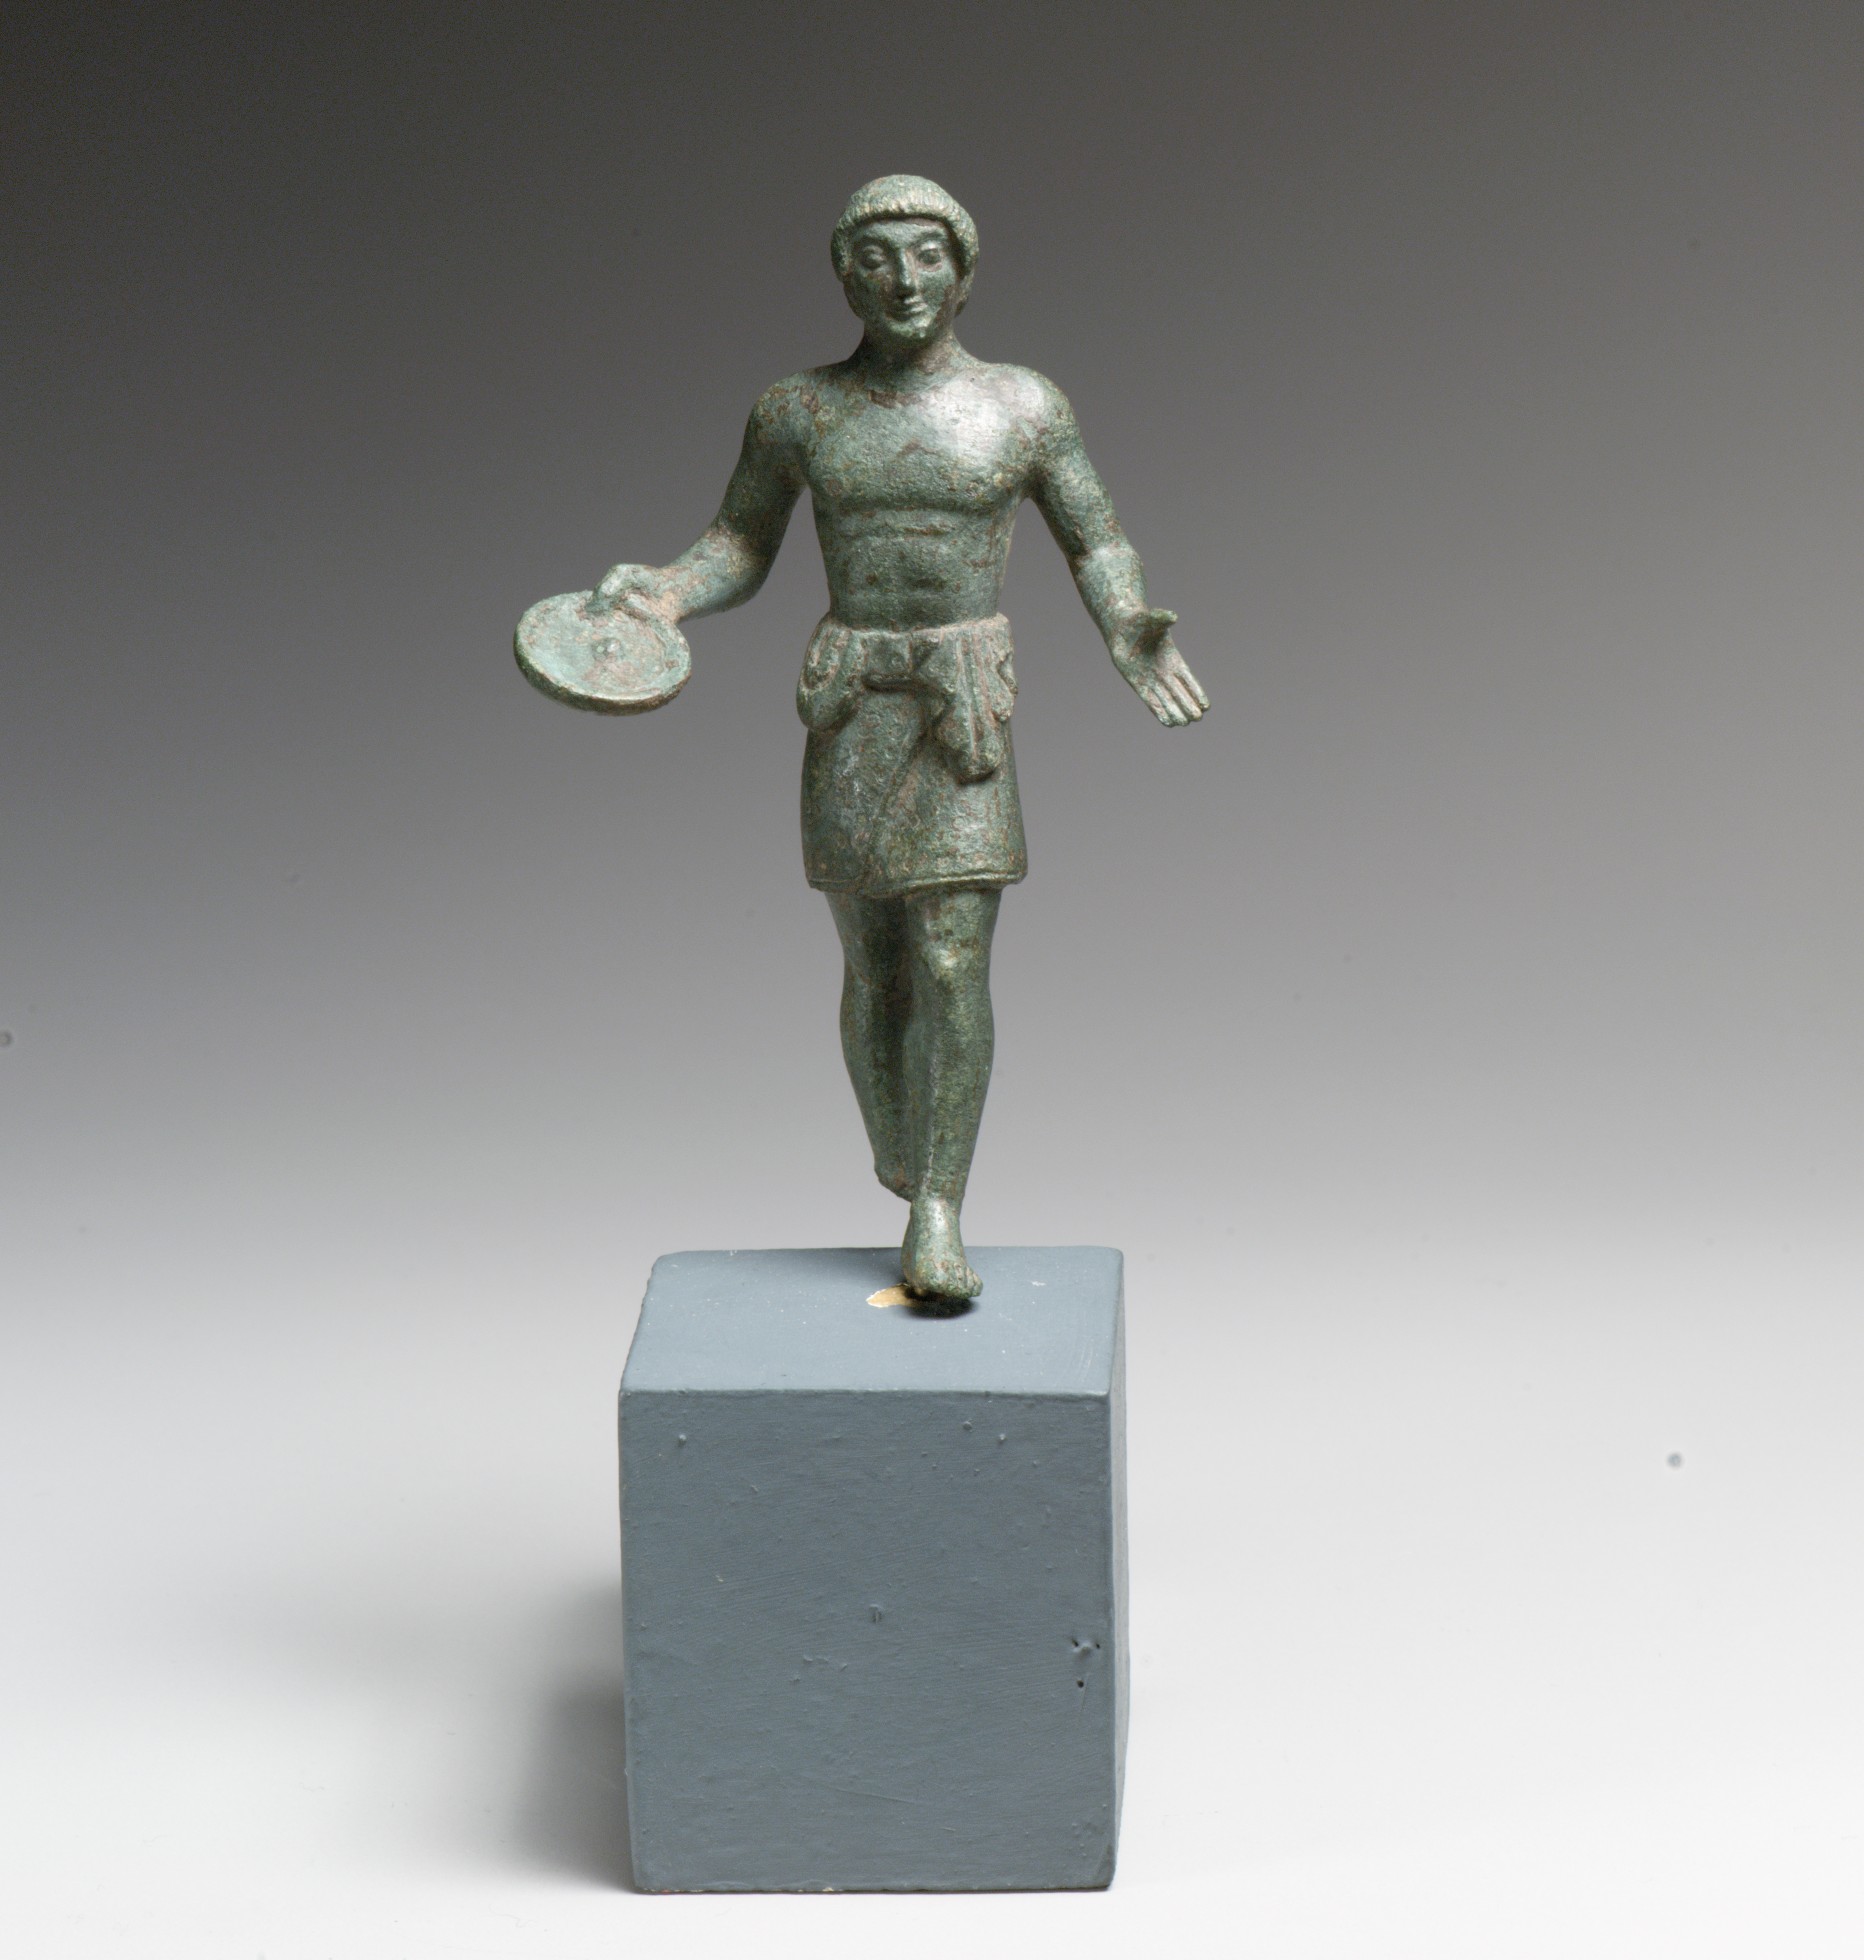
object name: statuette of a youth with phiale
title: Bronze statuette of a youth with phiale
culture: etruscan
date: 900-100 BCE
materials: bronze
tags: men